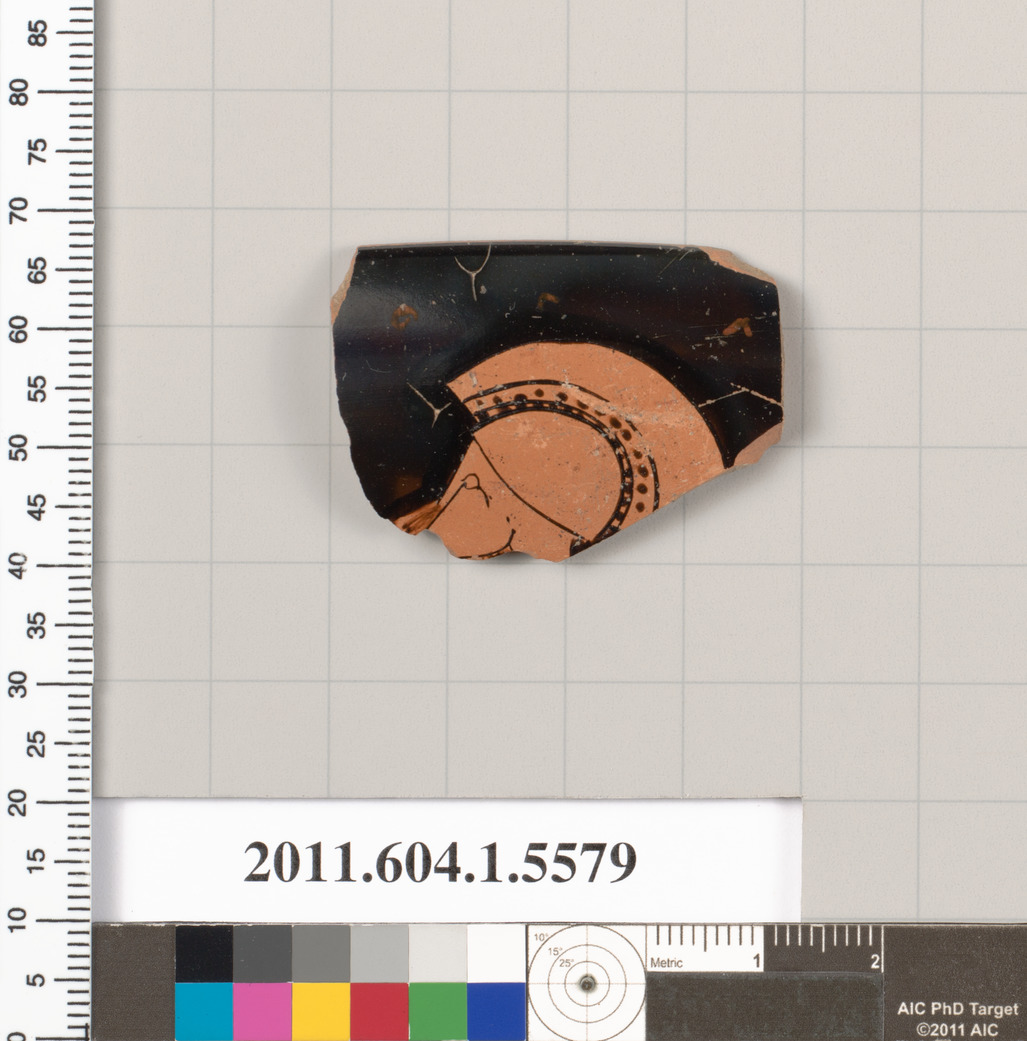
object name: kylix fragment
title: Terracotta rim fragment of a kylix (drinking cup)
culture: greek, attic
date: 490-480 BCE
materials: terracotta